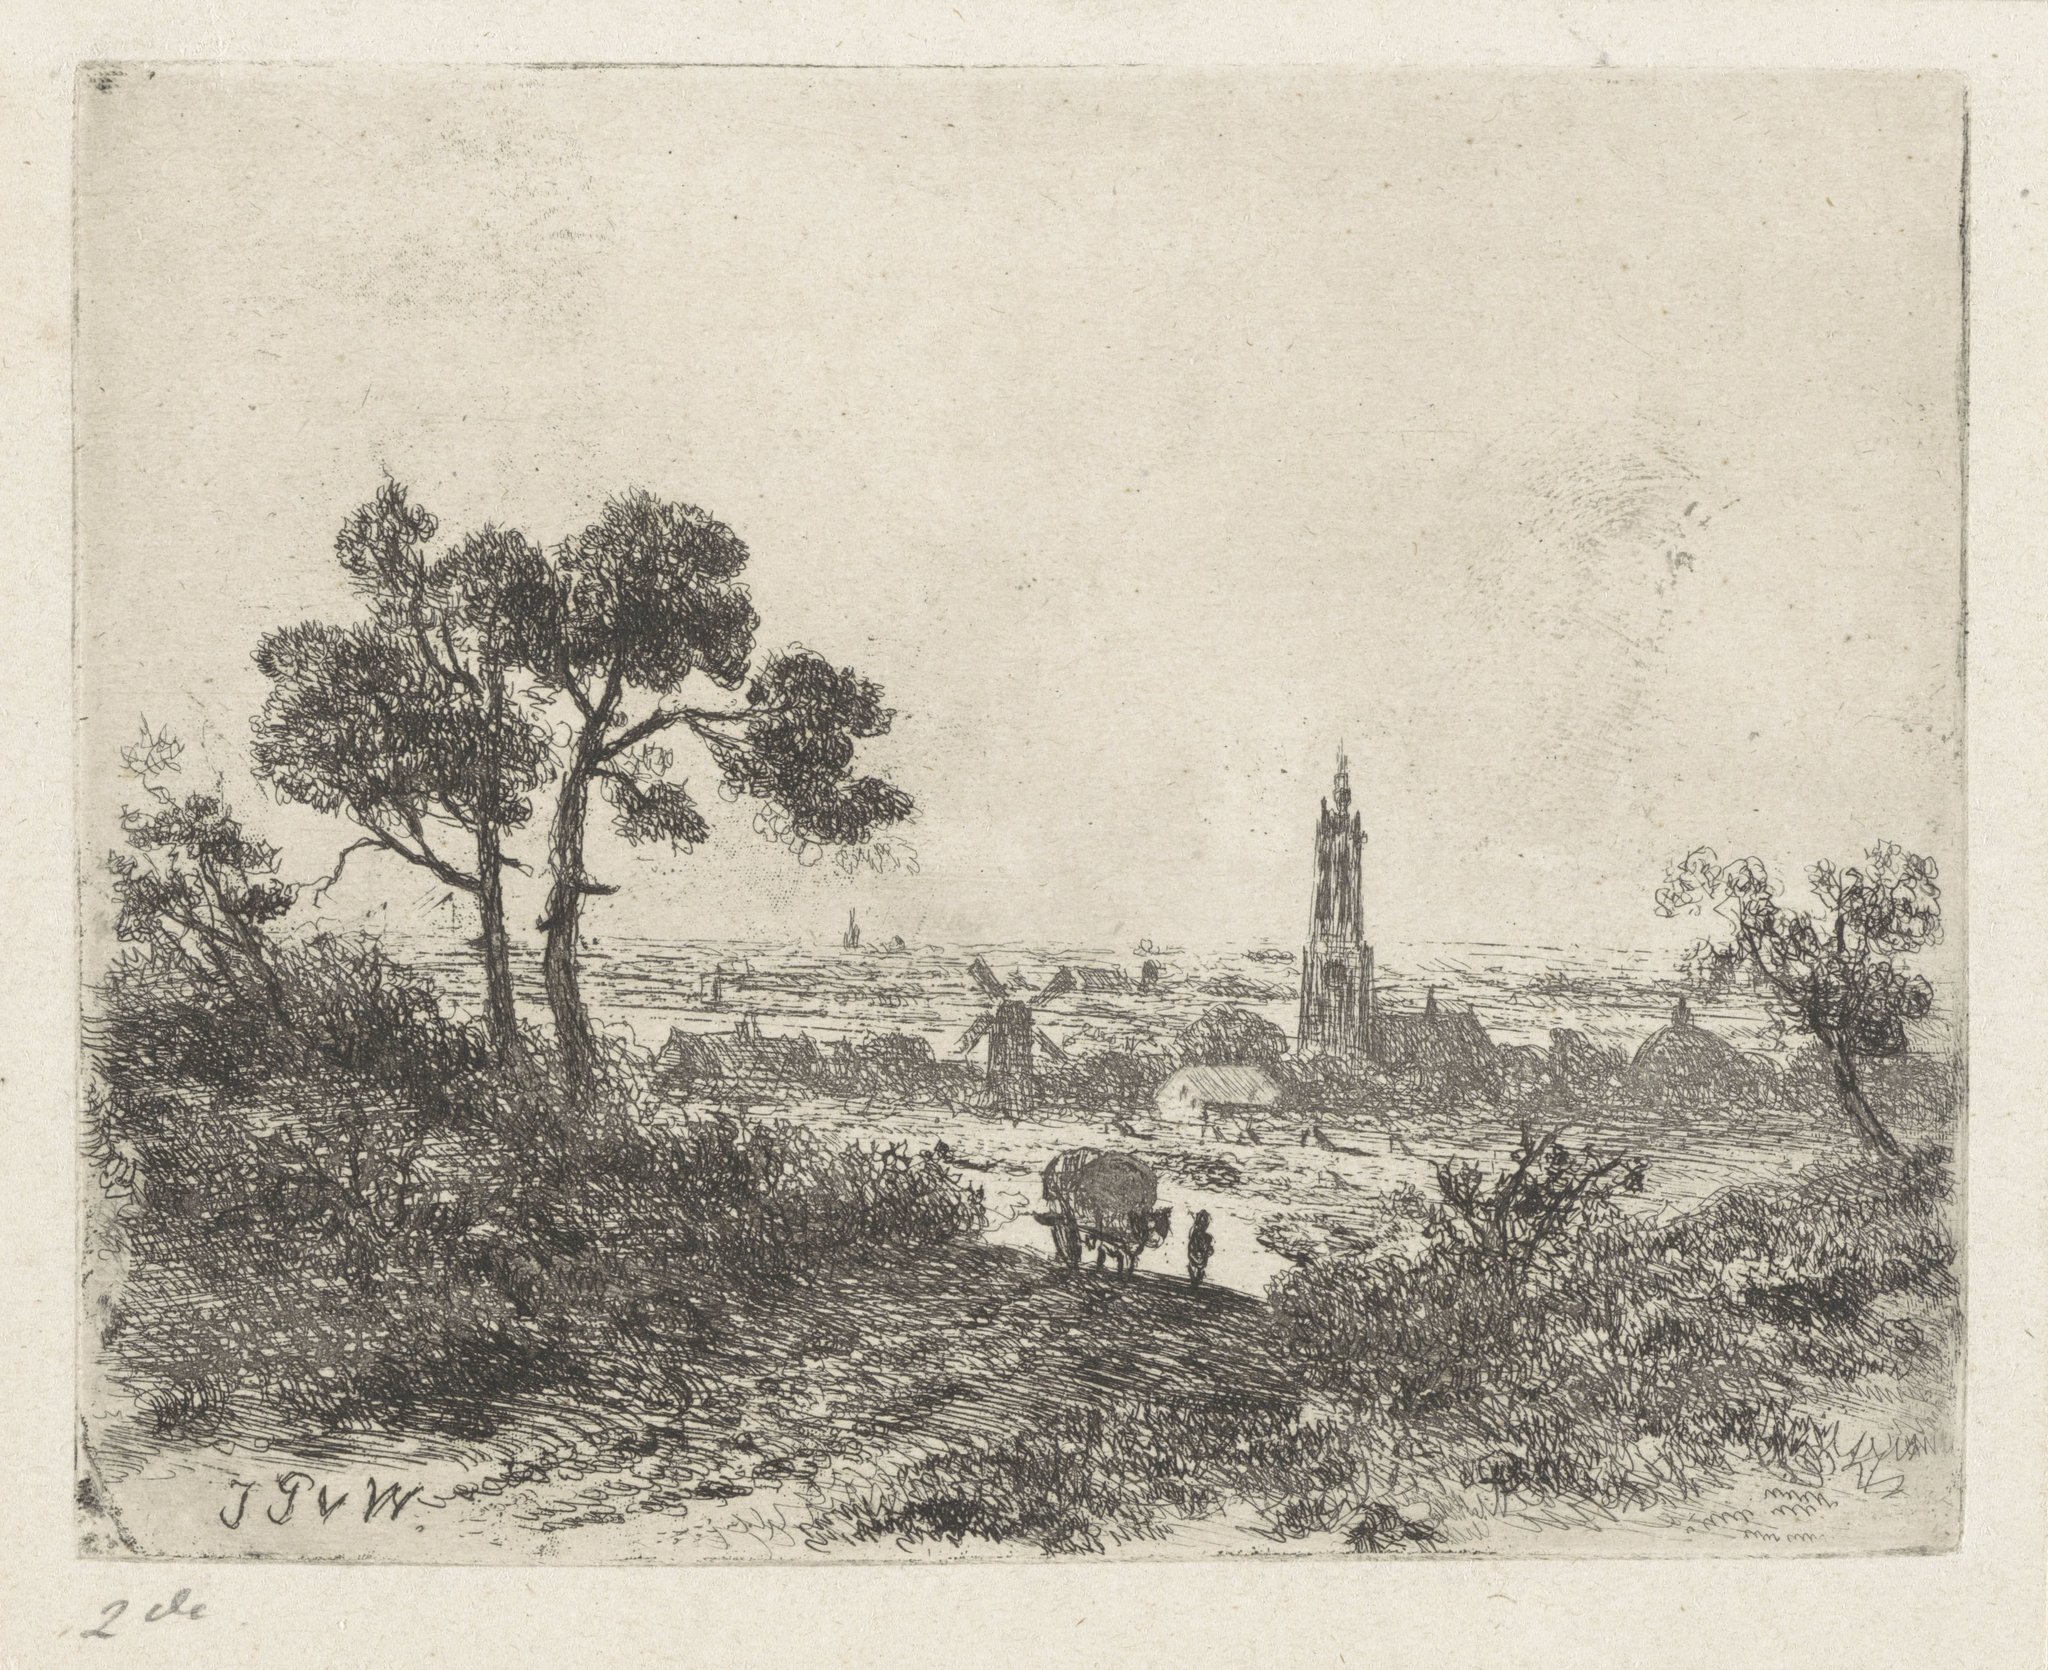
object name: print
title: Gezicht op Rhenen(?)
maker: johannes pieter van wisselingh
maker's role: draughtsman, painter, print maker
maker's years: 1812-1899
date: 1830-1878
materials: paper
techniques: etching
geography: netherlands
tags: city-view, and landscape with man-made constructions, church (exterior), road, path, windmill, (farm) wagon, freight wagon, cart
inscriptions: collector's mark: Lugt 2228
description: Gezicht op een stad, Rhenen(?), met een kerk en een molen. Vooraan een paard-en-wagen met een figuur op een landweg.